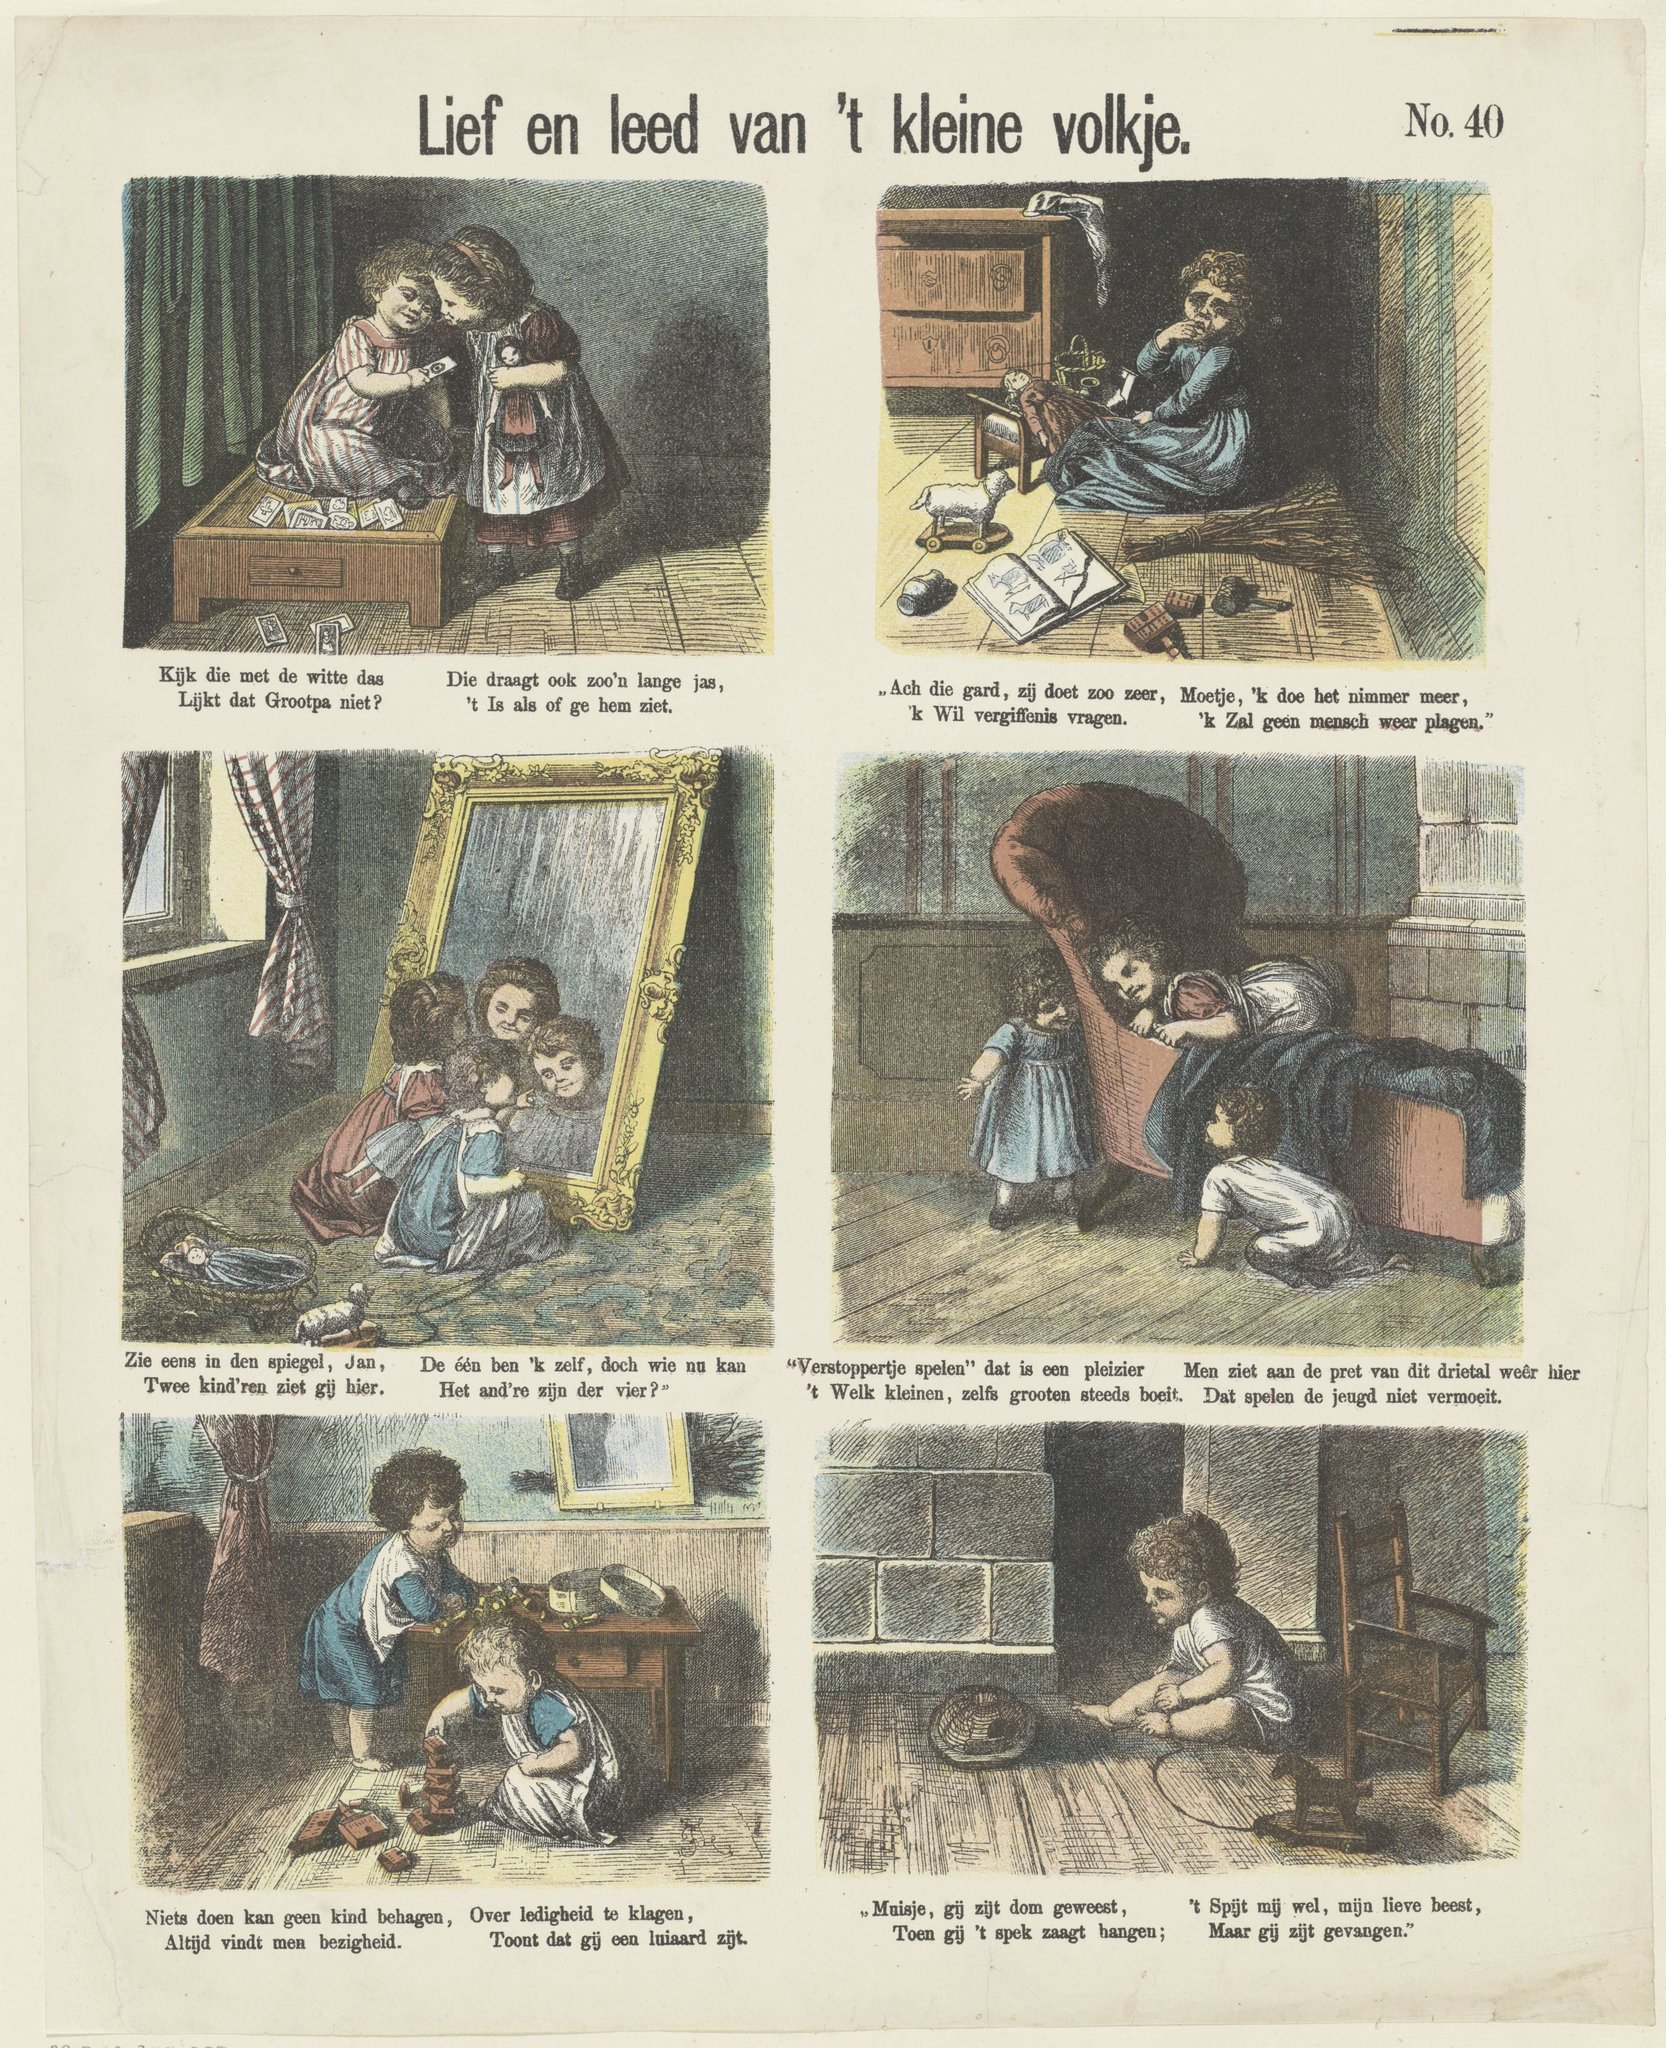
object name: popular print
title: Lief en leed van 't kleine volkje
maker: Anonymous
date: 1874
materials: paper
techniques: lithograph, letterpress printing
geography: amsterdam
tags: correction of naughty children, children's games and plays, bad behaviour, good behaviour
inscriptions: collector's mark: Lugt 2760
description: Blad met 6 voorstellingen van het goede en slechte gedrag van kinderen, waaronder voorstellingen van kinderen die foto's kijken, een pak slaag verdienen, in de spiegel kijken, verstoppertje spelen, een toren bouwen en een muis vangen. Onder elke afbeelding een vierregelig vers in twee kolommen. Genummerd rechtsboven: No. 40.